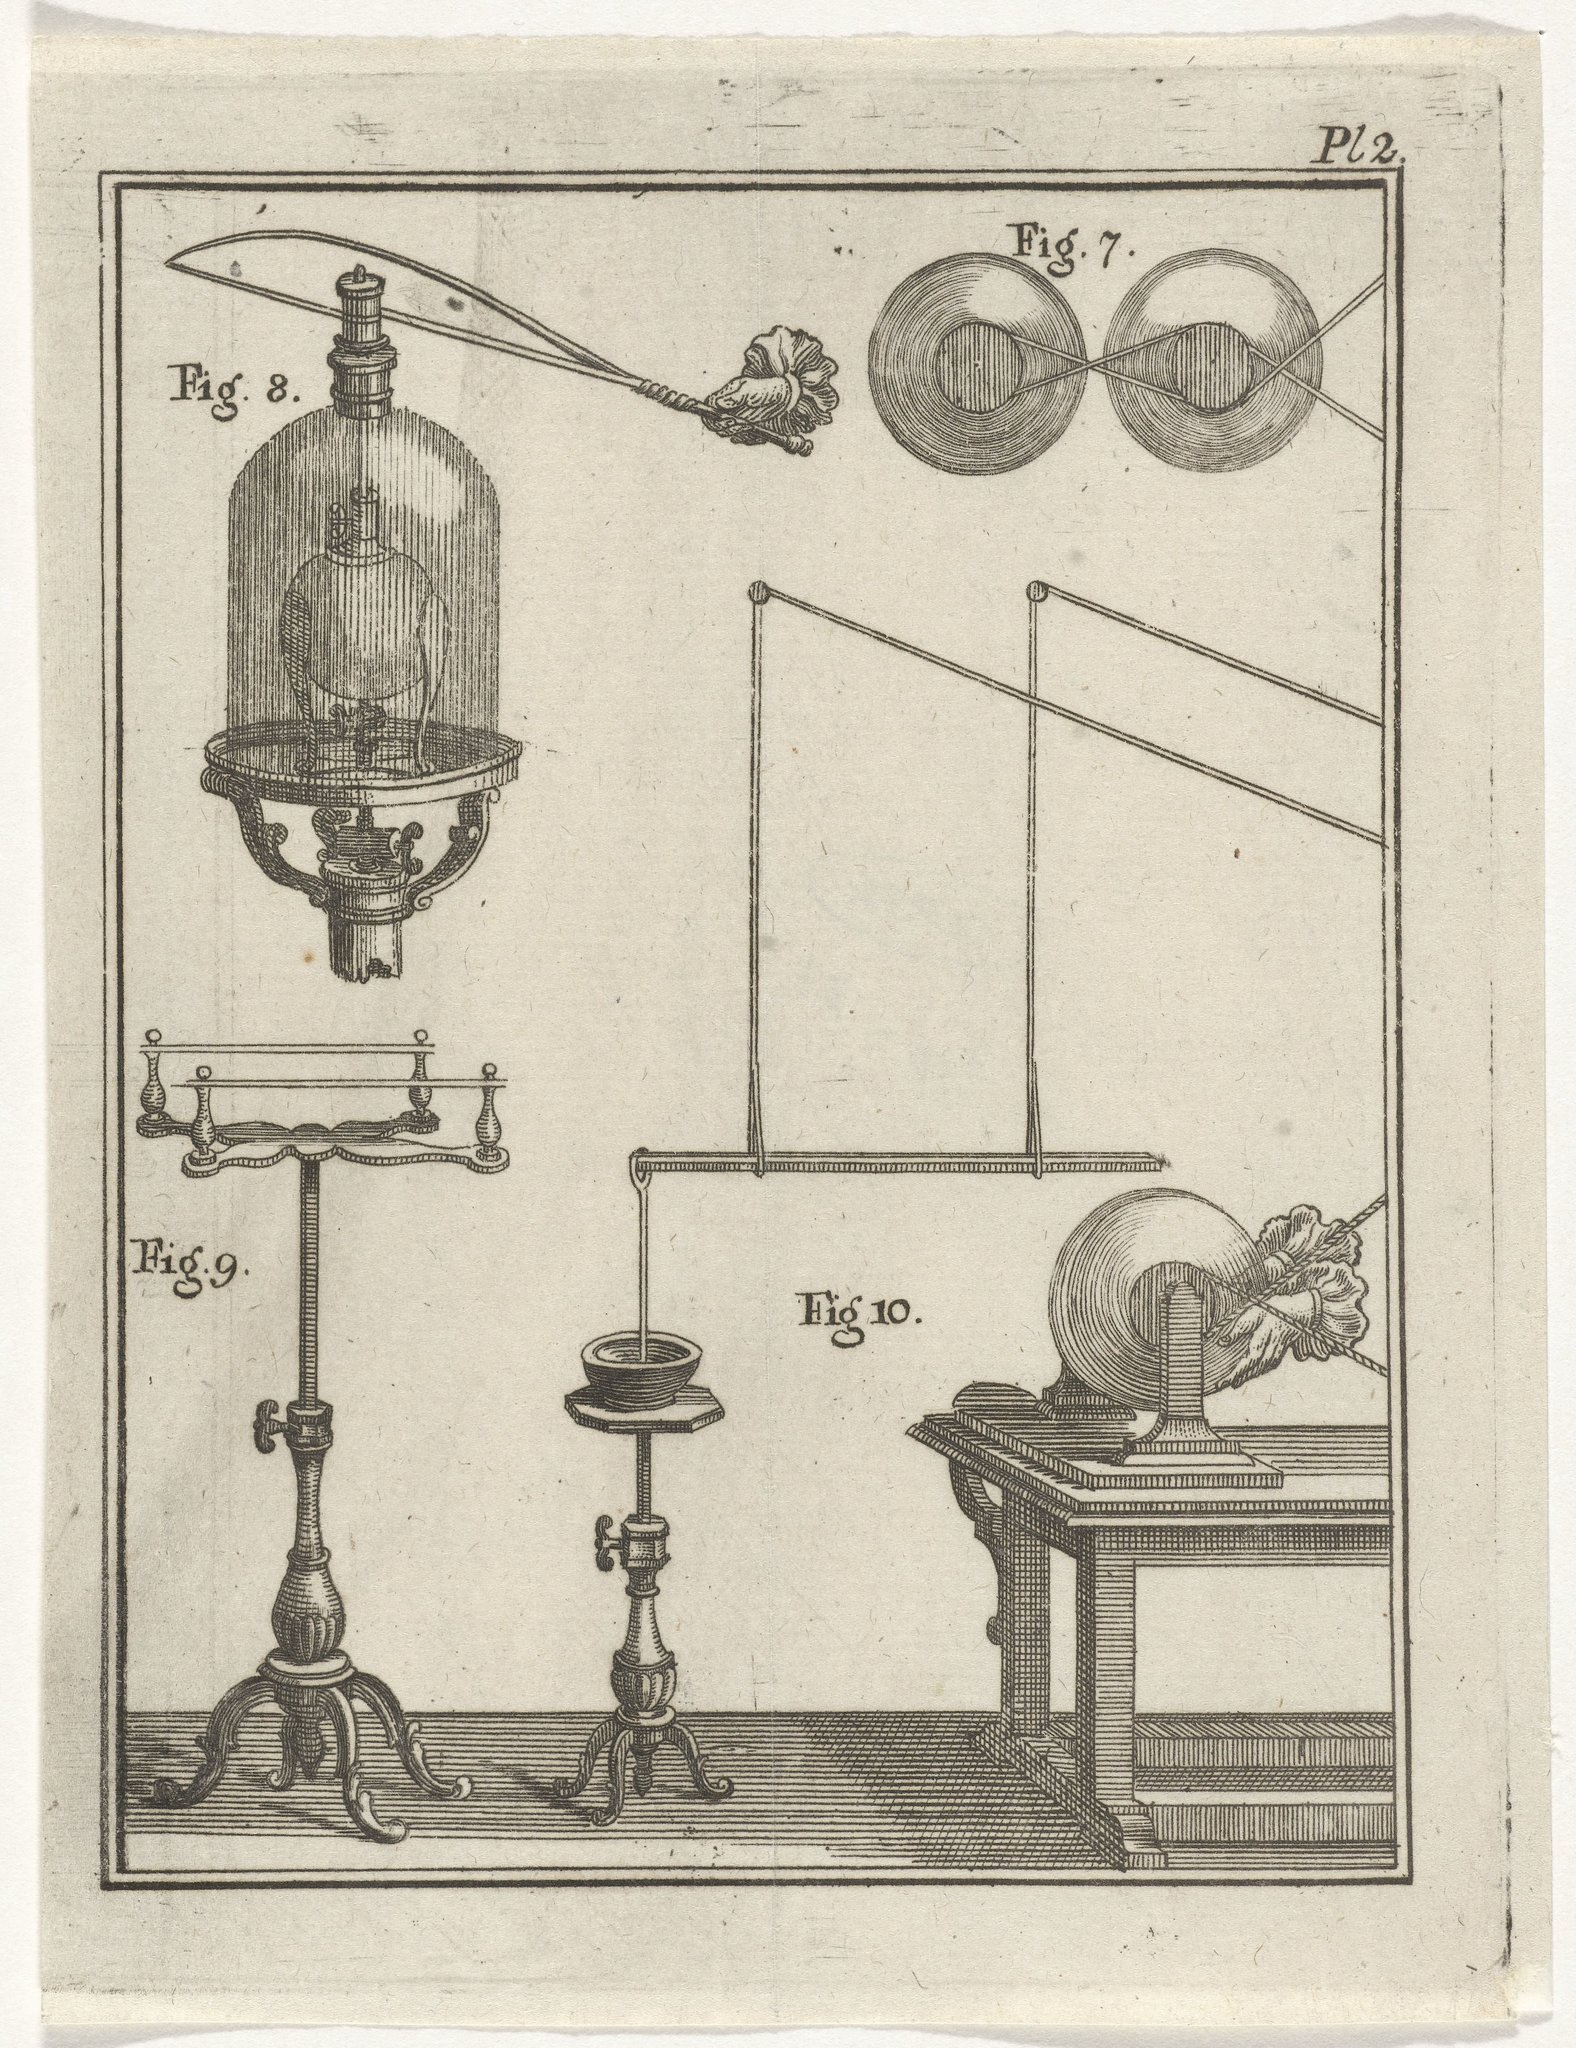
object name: print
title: Natuurkundige instrumenten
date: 1759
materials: paper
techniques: etching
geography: amsterdam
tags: physics (+ tools, instruments; laboratory equipment ~ scientific research)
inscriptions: collector's mark: Lugt 2228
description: Illustratie voor: Nollet, Jean Antoine. Natuurkundige lessen, door proefneemingen bevestigd, eerste deel. Amsterdam: Kornelis van Tongerlo, 1759.